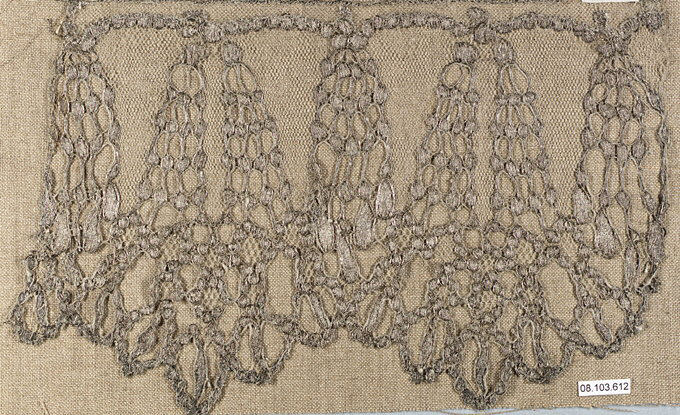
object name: piece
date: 1701-1800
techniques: lace